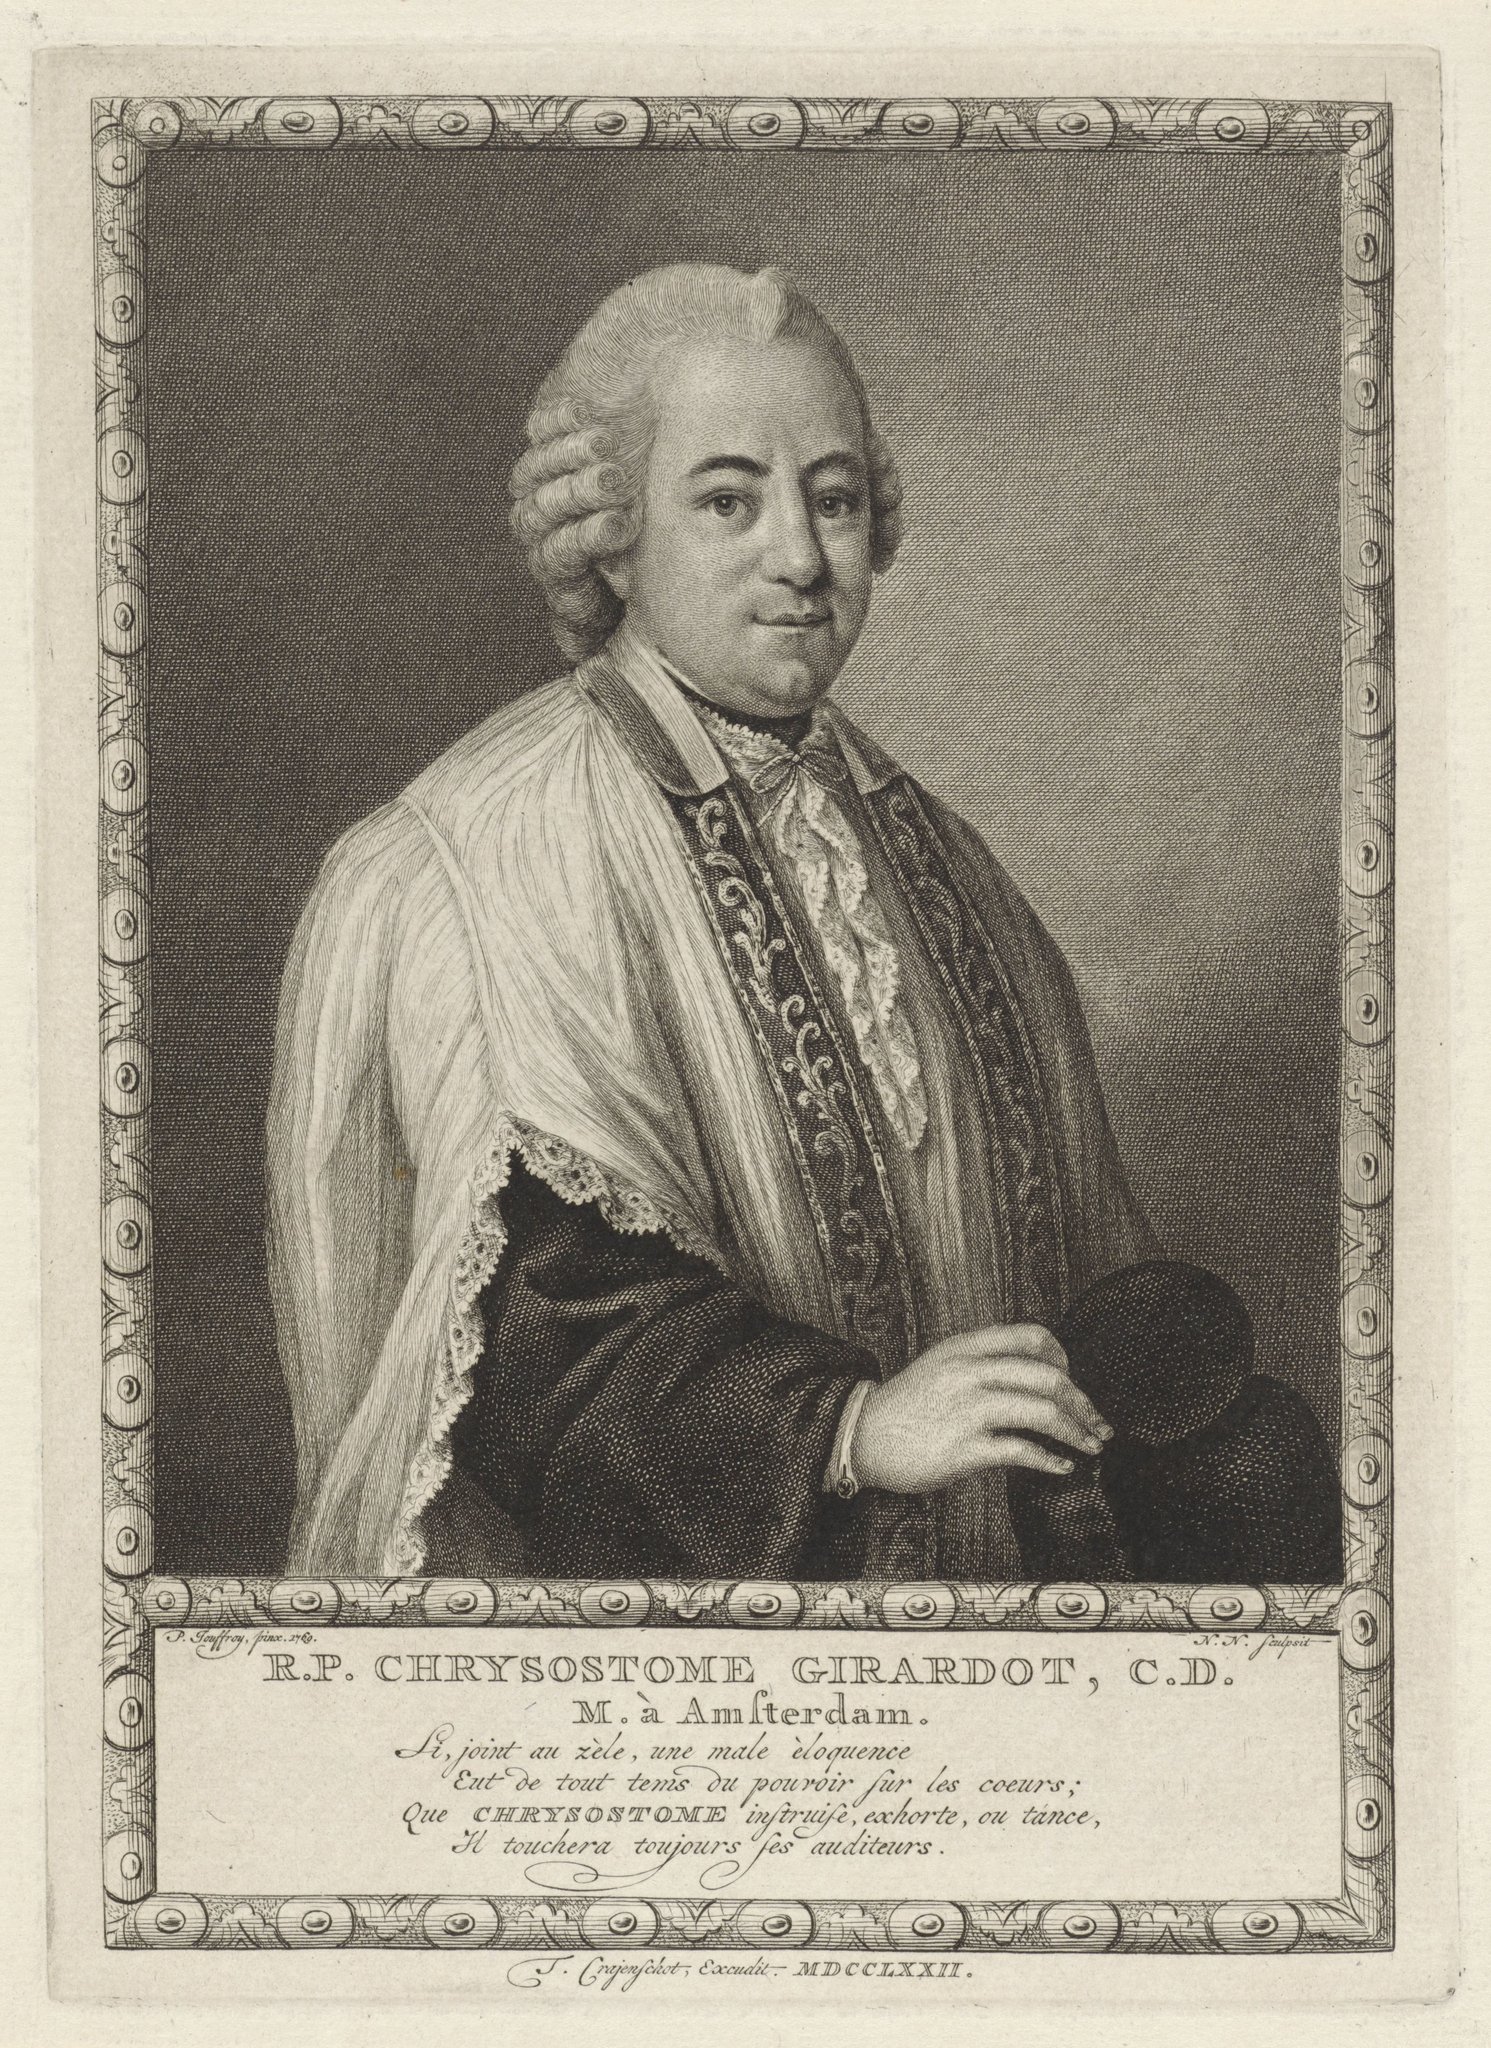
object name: print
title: Portret van Chrysostome Girardot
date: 1772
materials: paper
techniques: engraving, etching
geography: amsterdam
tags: priest (roman catholic)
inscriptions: collector's mark: Lugt 2228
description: Portret van Chrysostome Girardot, Frans pastoor te Amsterdam, gekleed in zijn priesterkleed.